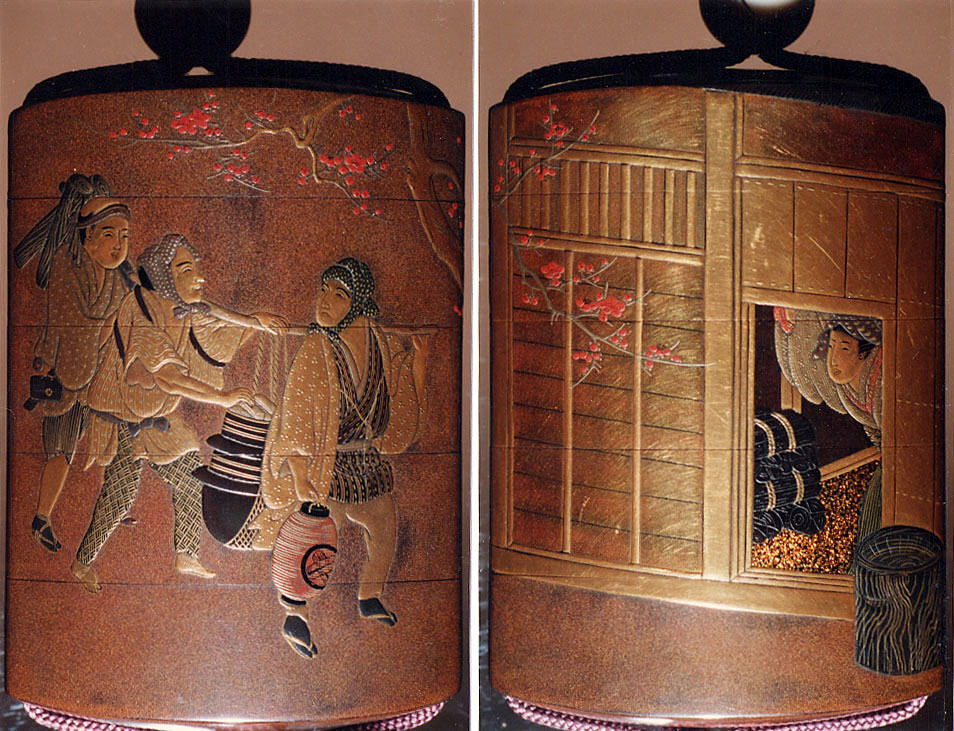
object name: inrō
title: Case (Inrō) with Design of a Teahouse (obverse) Three Travelers En Route (reverse)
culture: japanese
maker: yamada jōkasai (1681–1704)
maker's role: artist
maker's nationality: japanese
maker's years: 1681-1704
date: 1801-1900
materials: gold, ivory, lacquer, wood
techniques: carving, hiramakie, polish, relief, maki-e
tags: men,women,cauldrons,tea houses